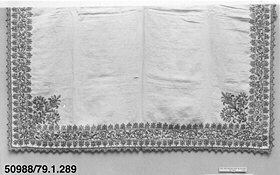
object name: cover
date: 1601-1800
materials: linen, silk